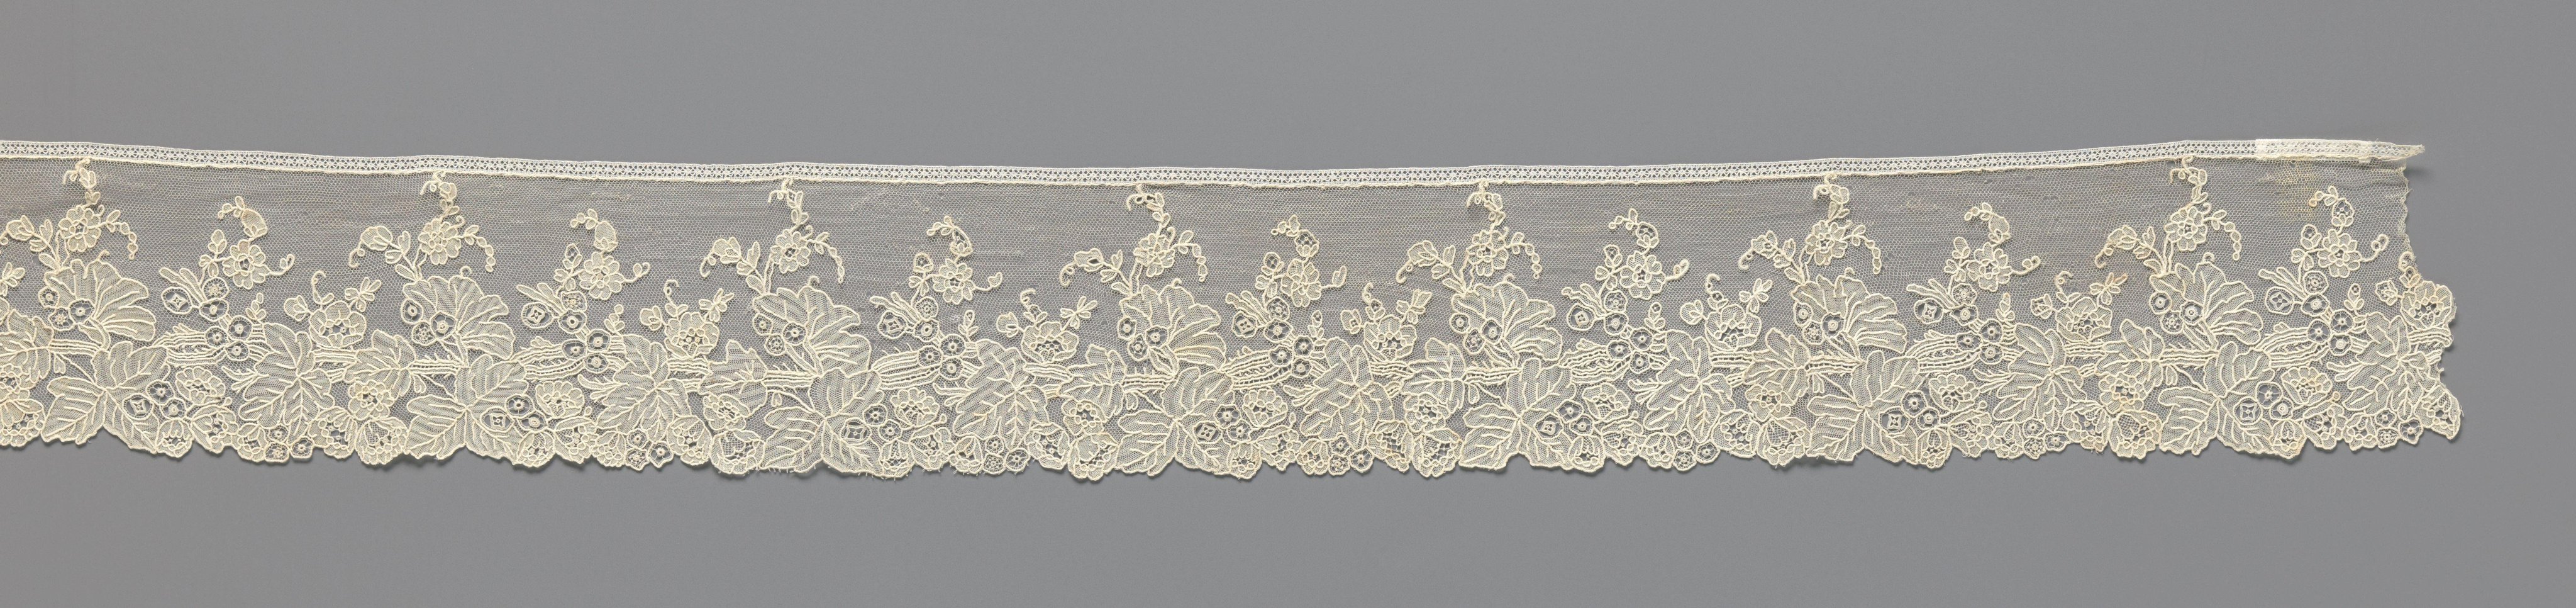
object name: strip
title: Strook naaldkant met grote bladeren en kleine bloemen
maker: Anonymous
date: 1880-1890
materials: linen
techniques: needle lace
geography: brussels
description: Strook naturelkleurig naaldkant, point de gaze de Bruxelles. Repetitief motief van grote bladeren en kleine bloemen op een fijne zeshoekig maasgrond, met enkelvoudige gedraaide mazen. Volwerk met verschillende zeer fijne maasgronden en siersteken. De schulpen langs de onderzijde worden gevormd door de onderzijde van het patroon met bladeren en bloemen. De bovenzijde is afgezet met een rand kloskant.